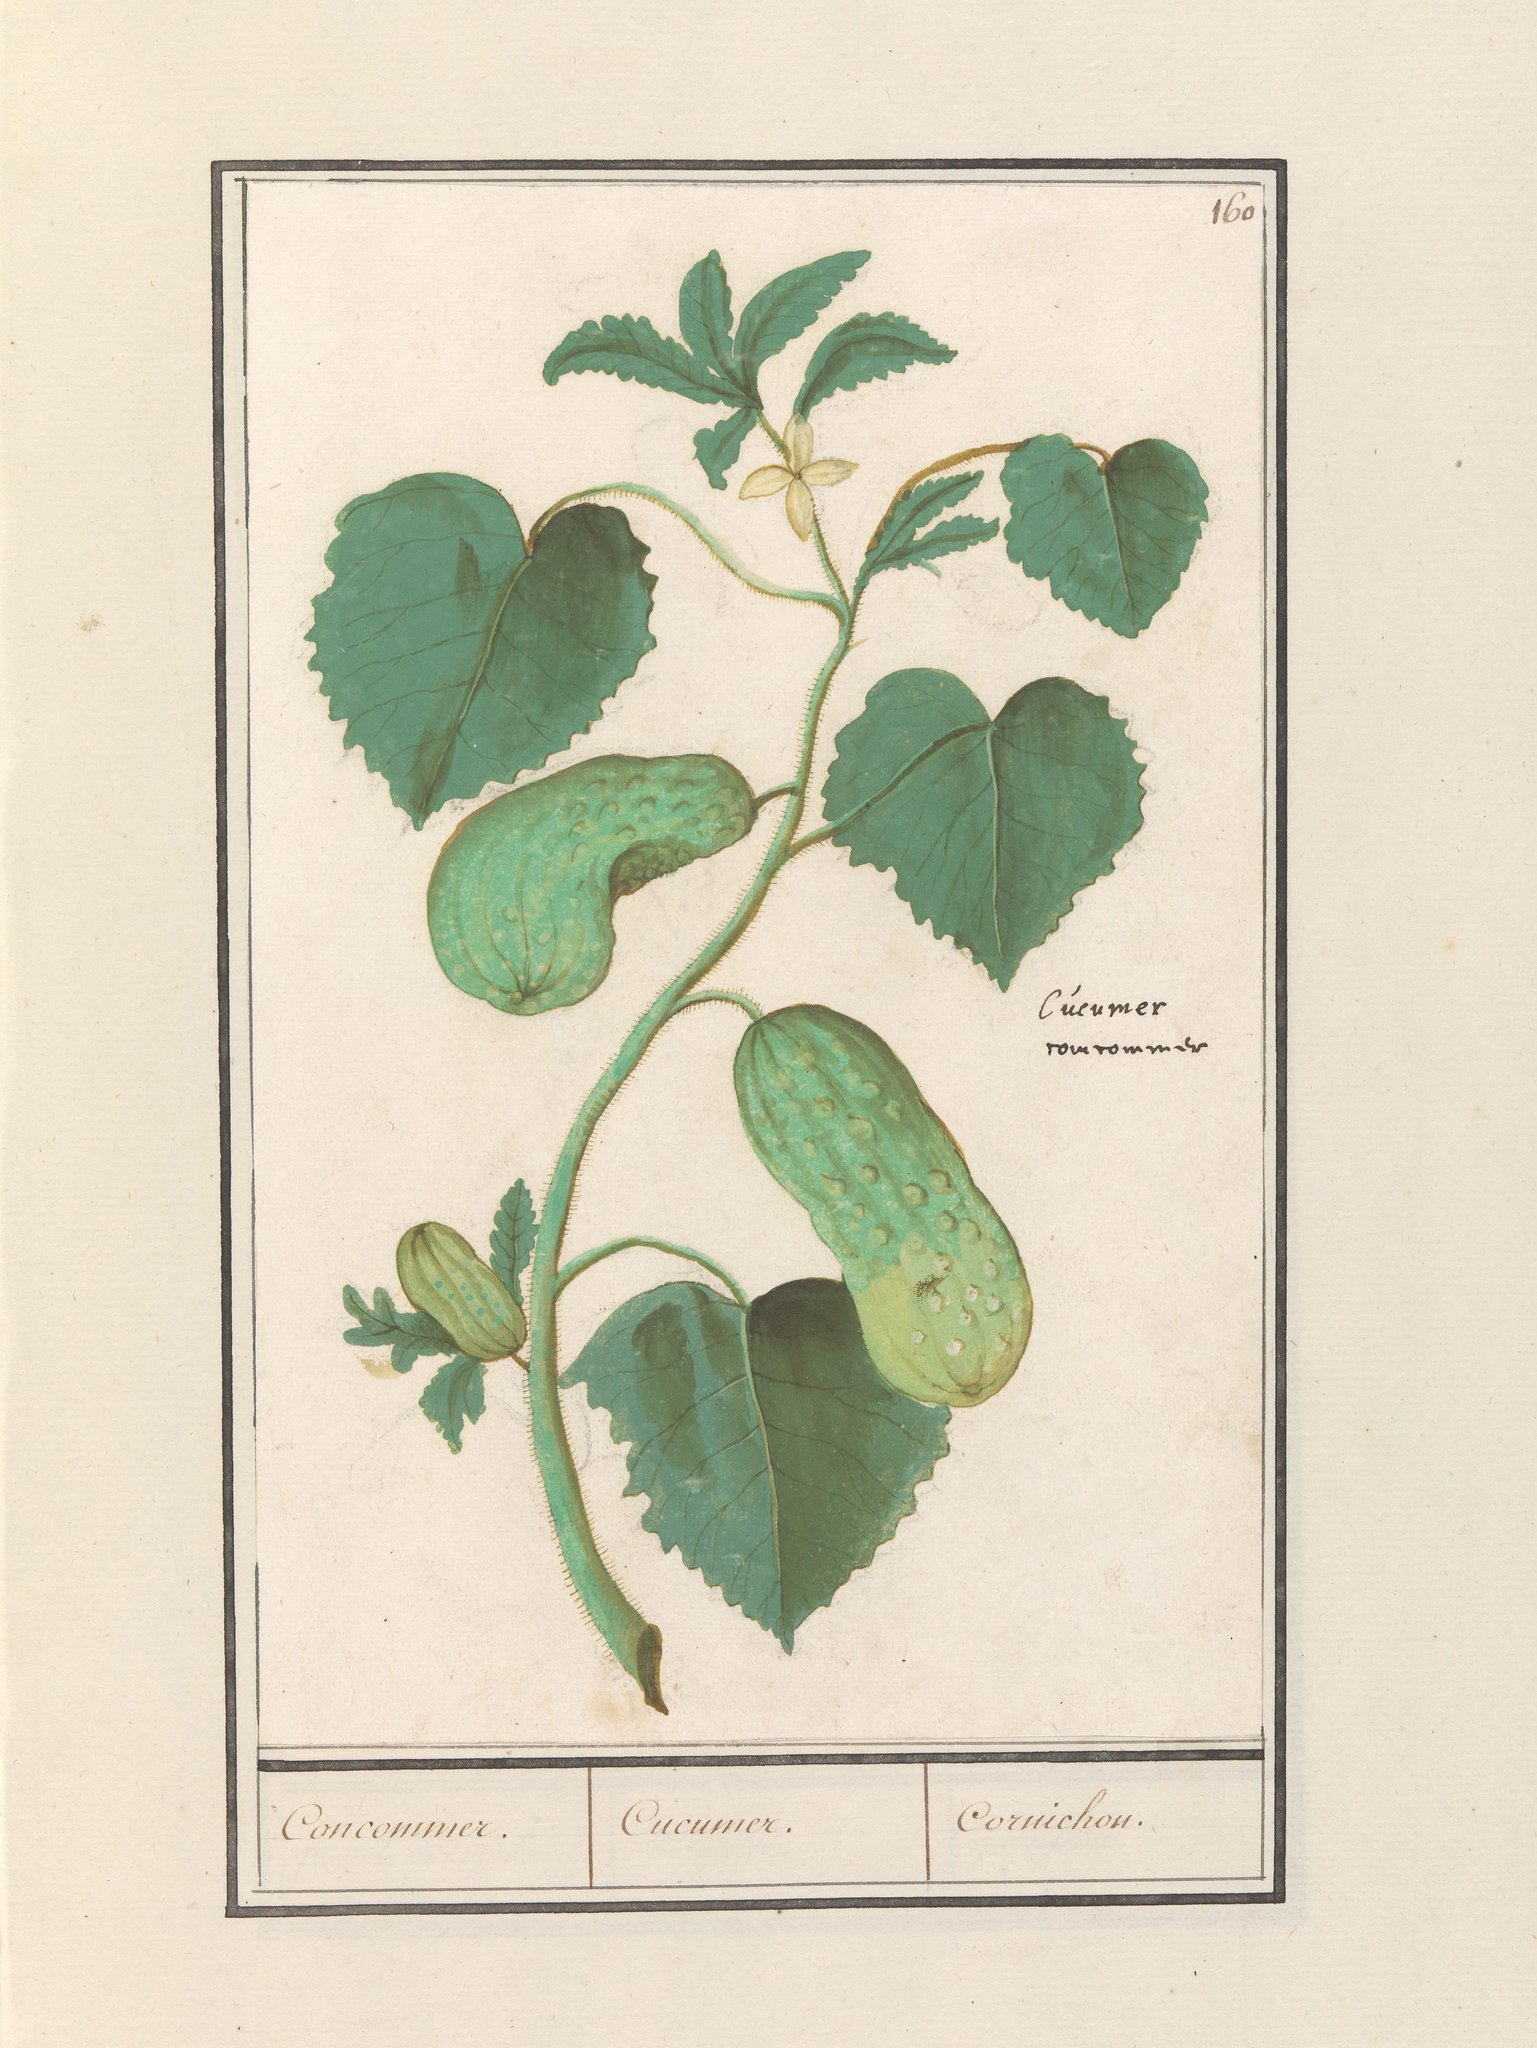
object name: drawing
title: Komkommer (Cucumis sativus)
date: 1596-1610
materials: chalk, paint, ink, paper, watercolor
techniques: brush, pen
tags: fruits: cucumber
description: Komkommer. Tak met bladeren, bloem en enkele vruchten. Rechtsboven genummerd: 160. Bij de vrucht de Latijnse naam. Onderdeel van het tweede album met tekeningen van bloemen en planten. Negende van twaalf albums met tekeningen van dieren, vogels en planten bekend rond 1600, gemaakt in opdracht van keizer Rudolf II. Met toelichting in Nederlands, Latijn en Frans.